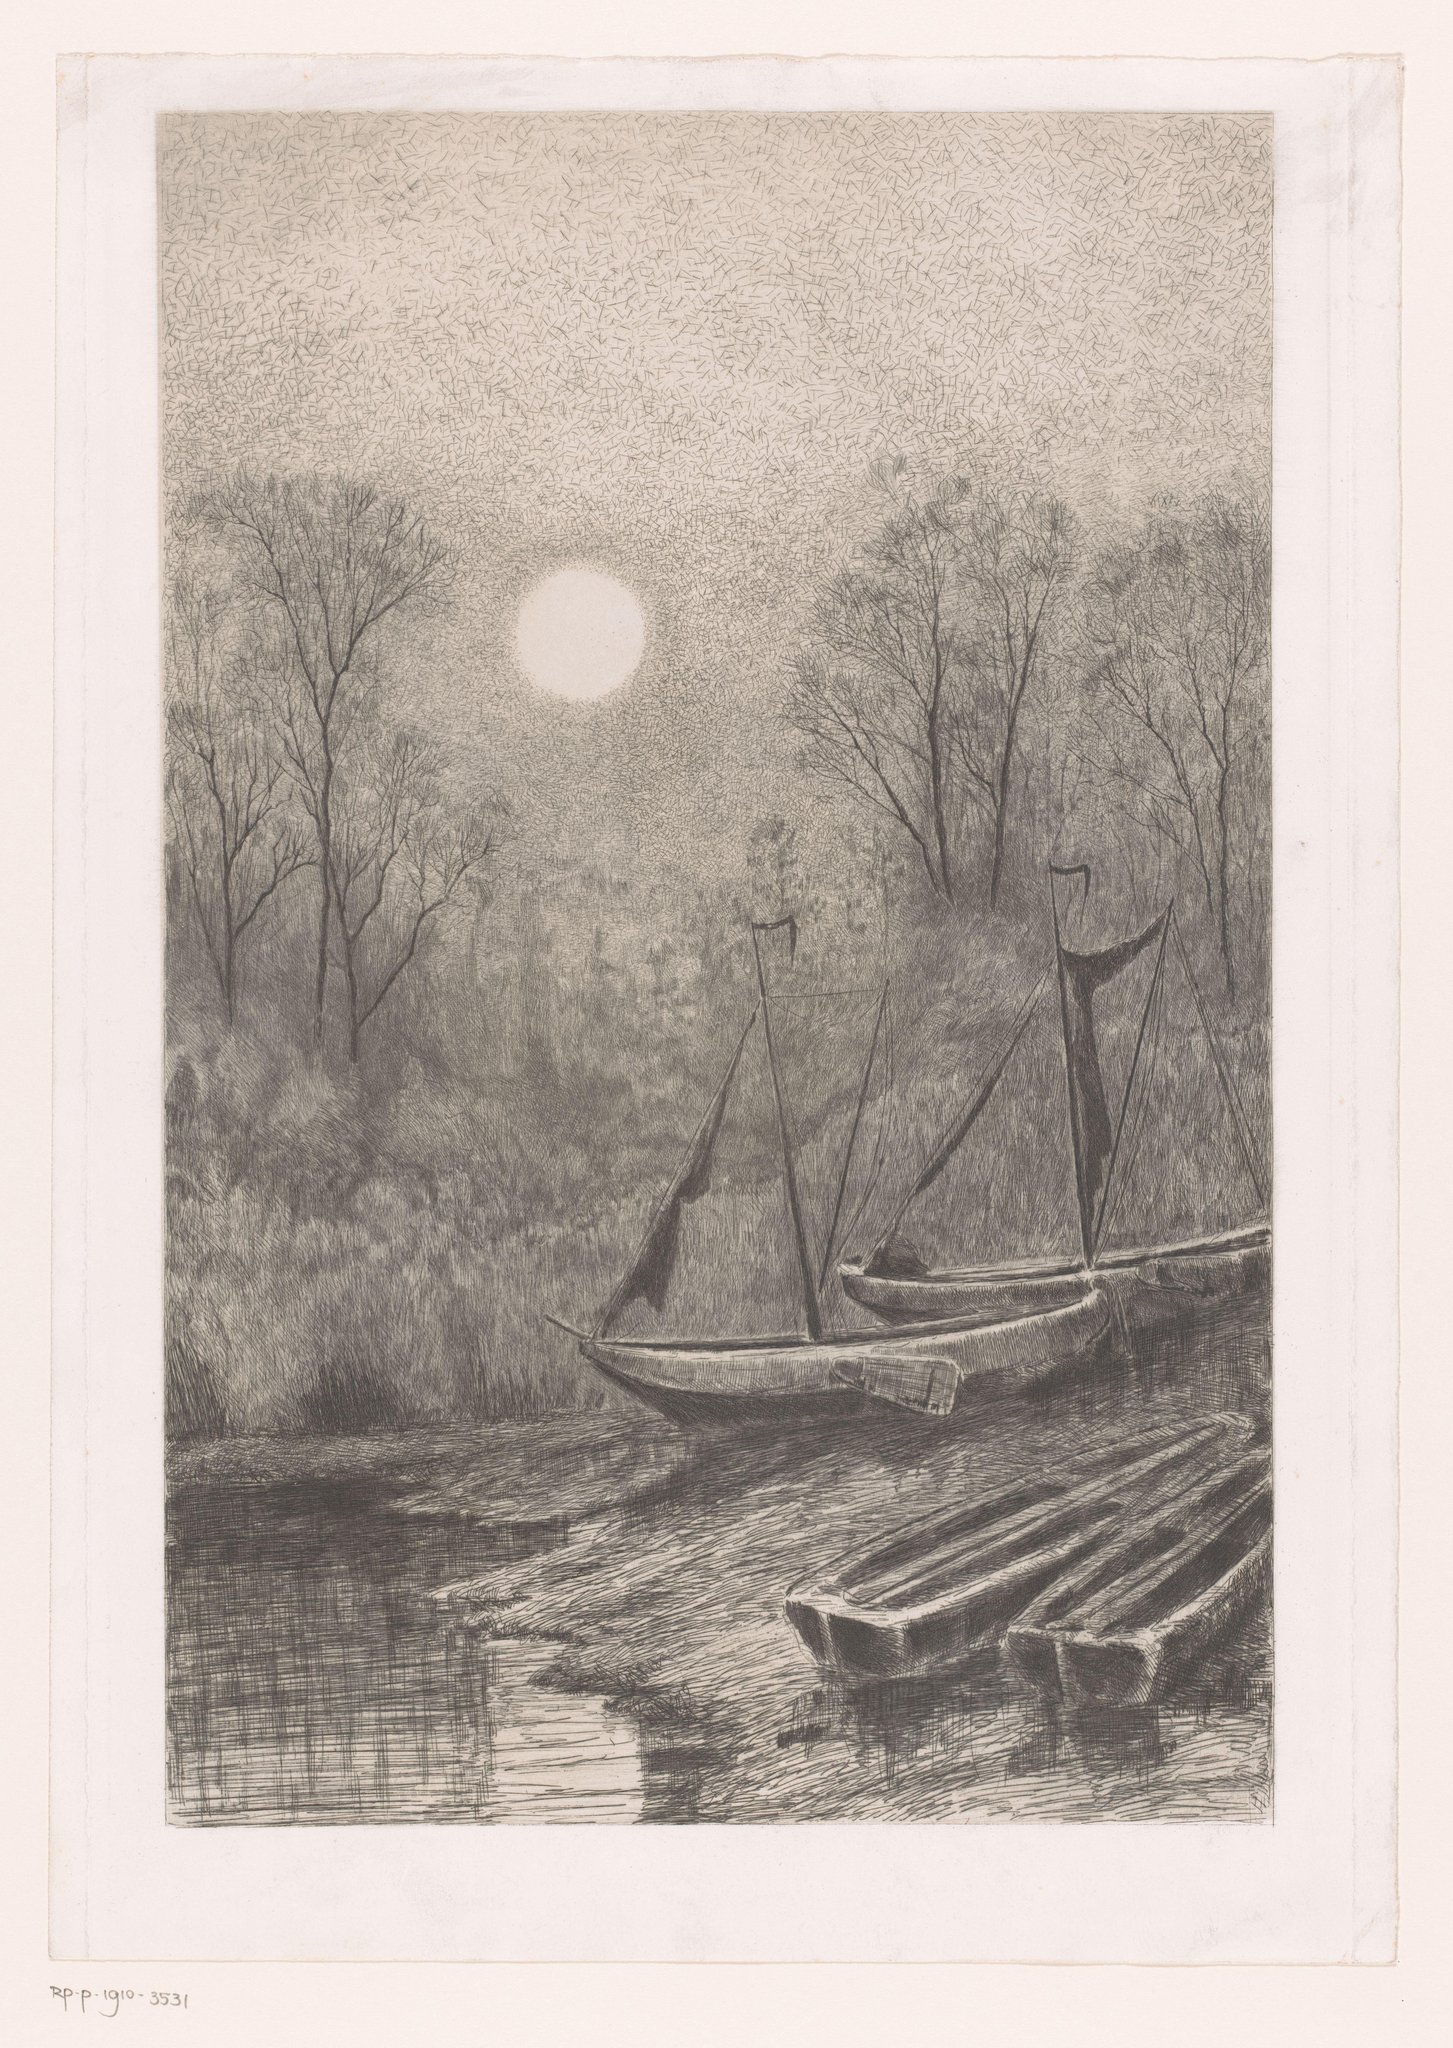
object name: print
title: Kleine zeilschepen op de kant bij maanlicht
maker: jules guiette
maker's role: print maker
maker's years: 1852-1901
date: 1862-1901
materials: paper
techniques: etching, intaglio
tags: sailing-ship, sailing-boat, moonlight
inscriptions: collector's mark: Lugt 2228